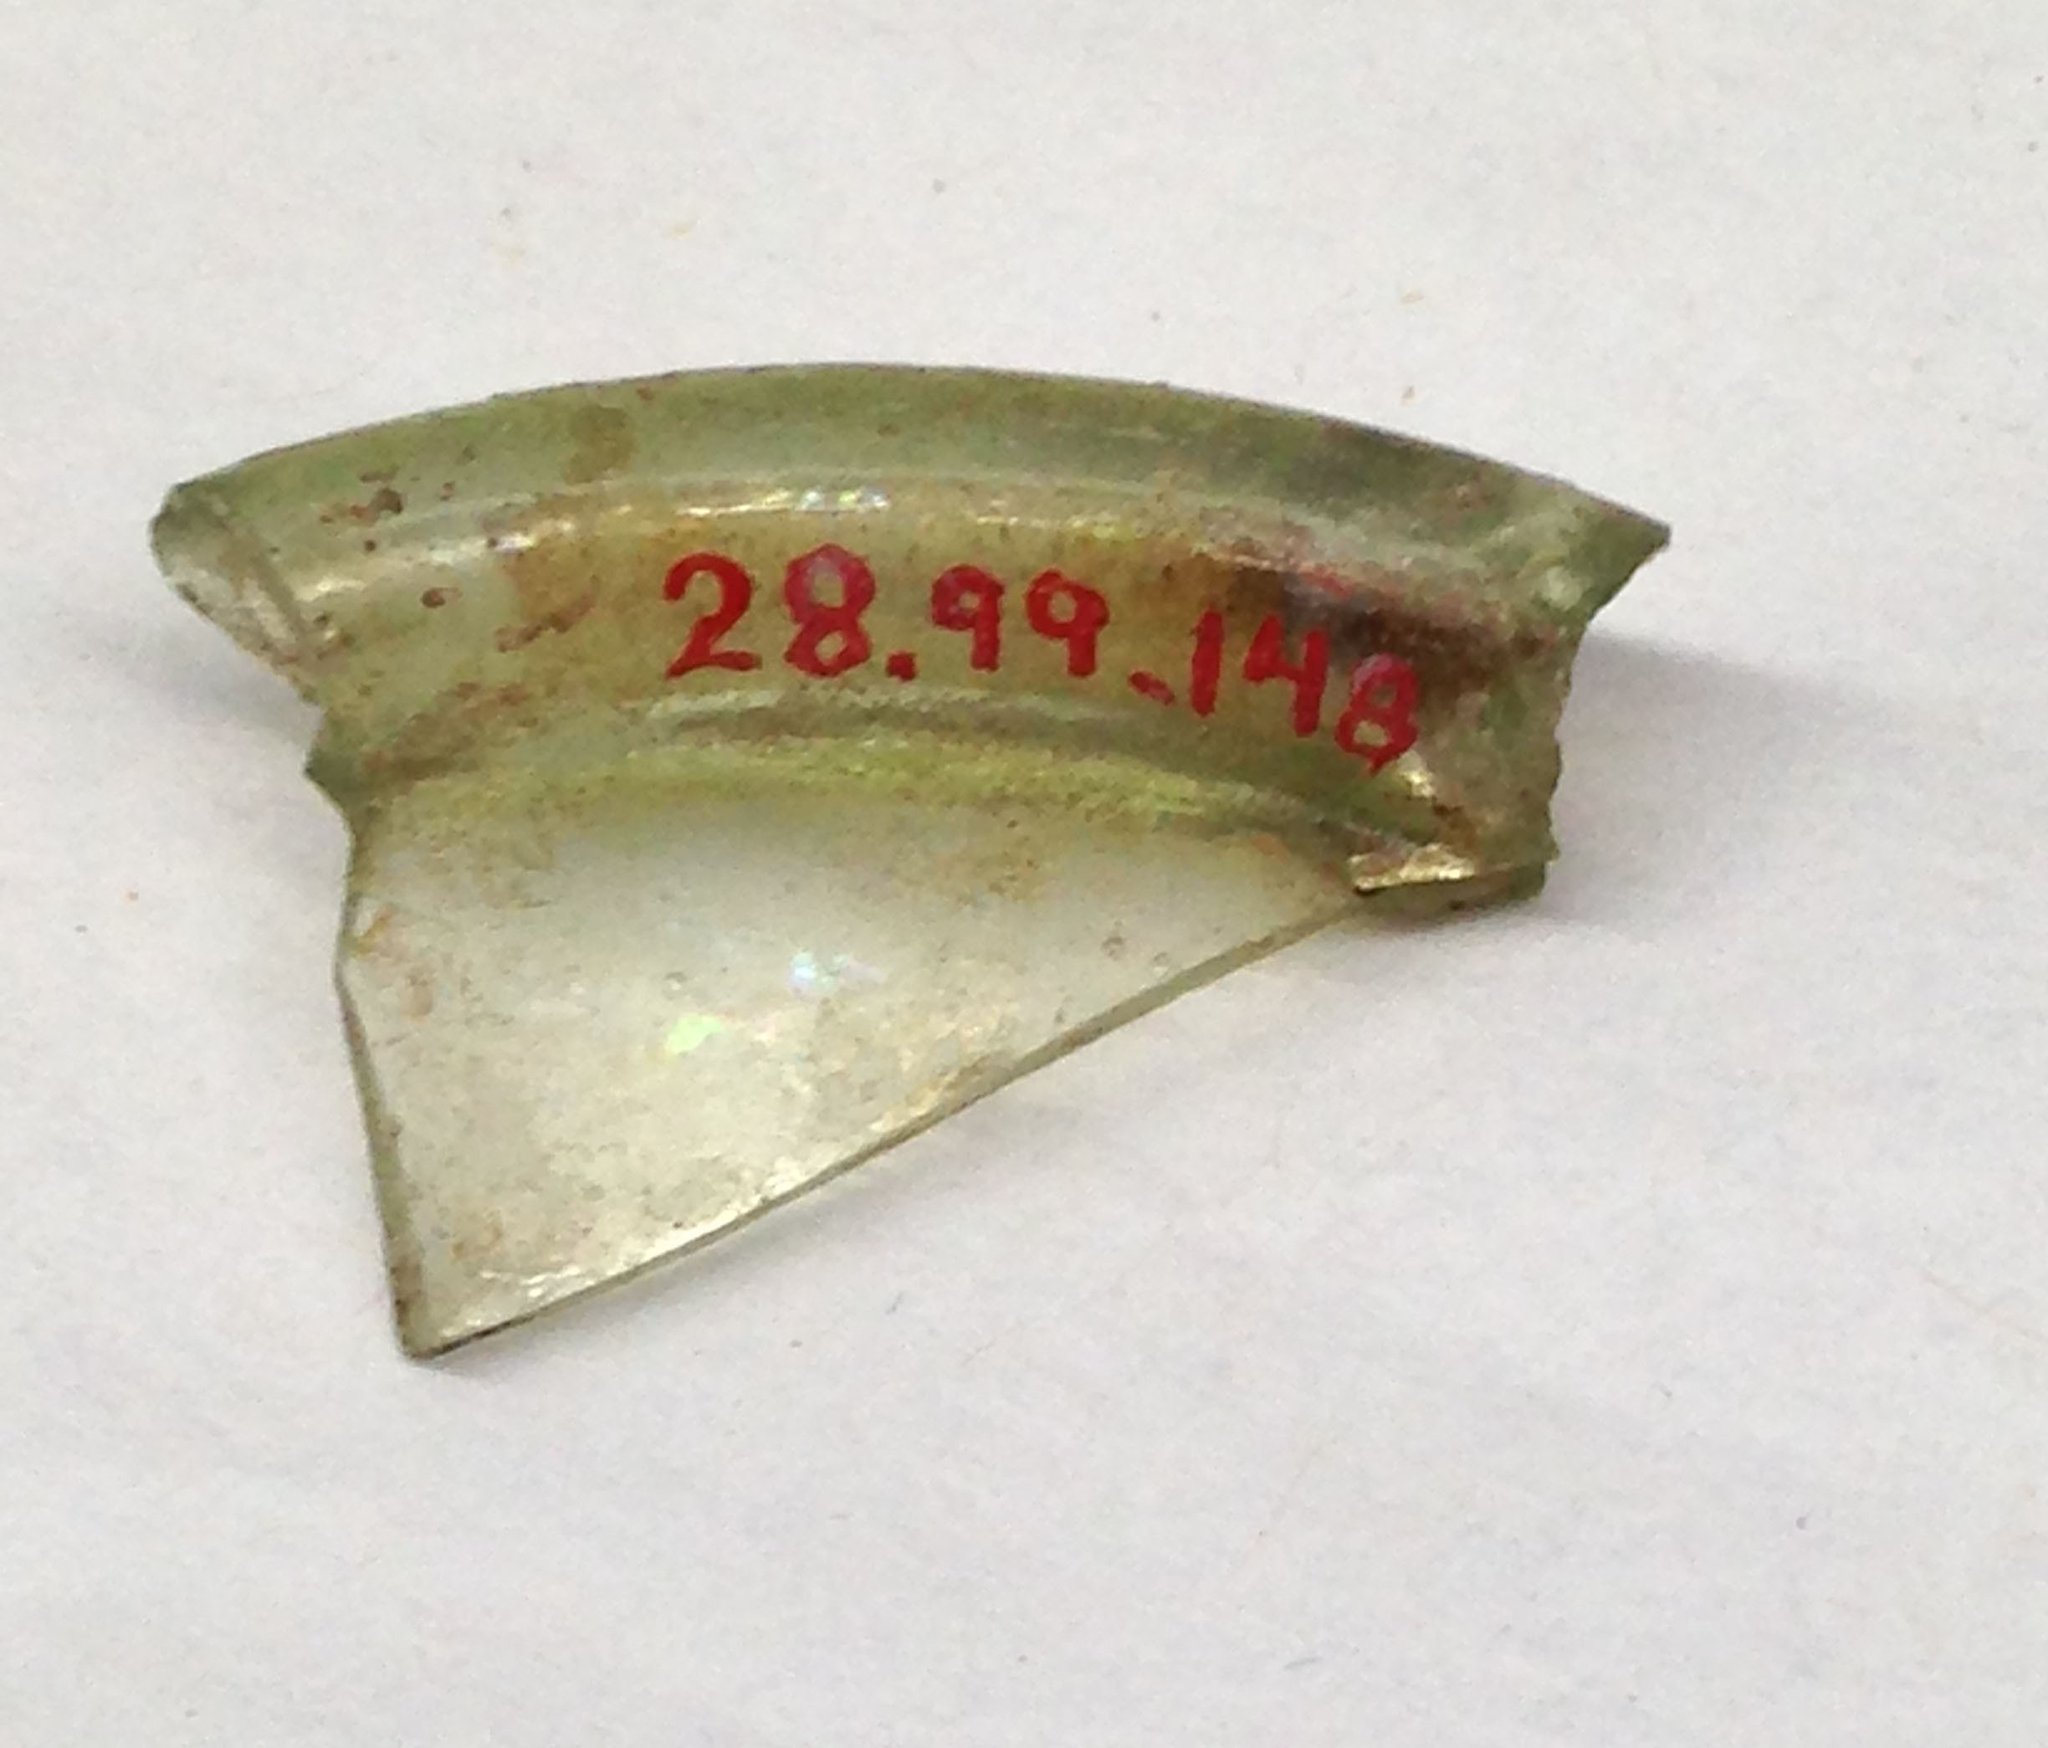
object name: fragment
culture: european or middle eastern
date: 1150-1250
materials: ceramic, glass